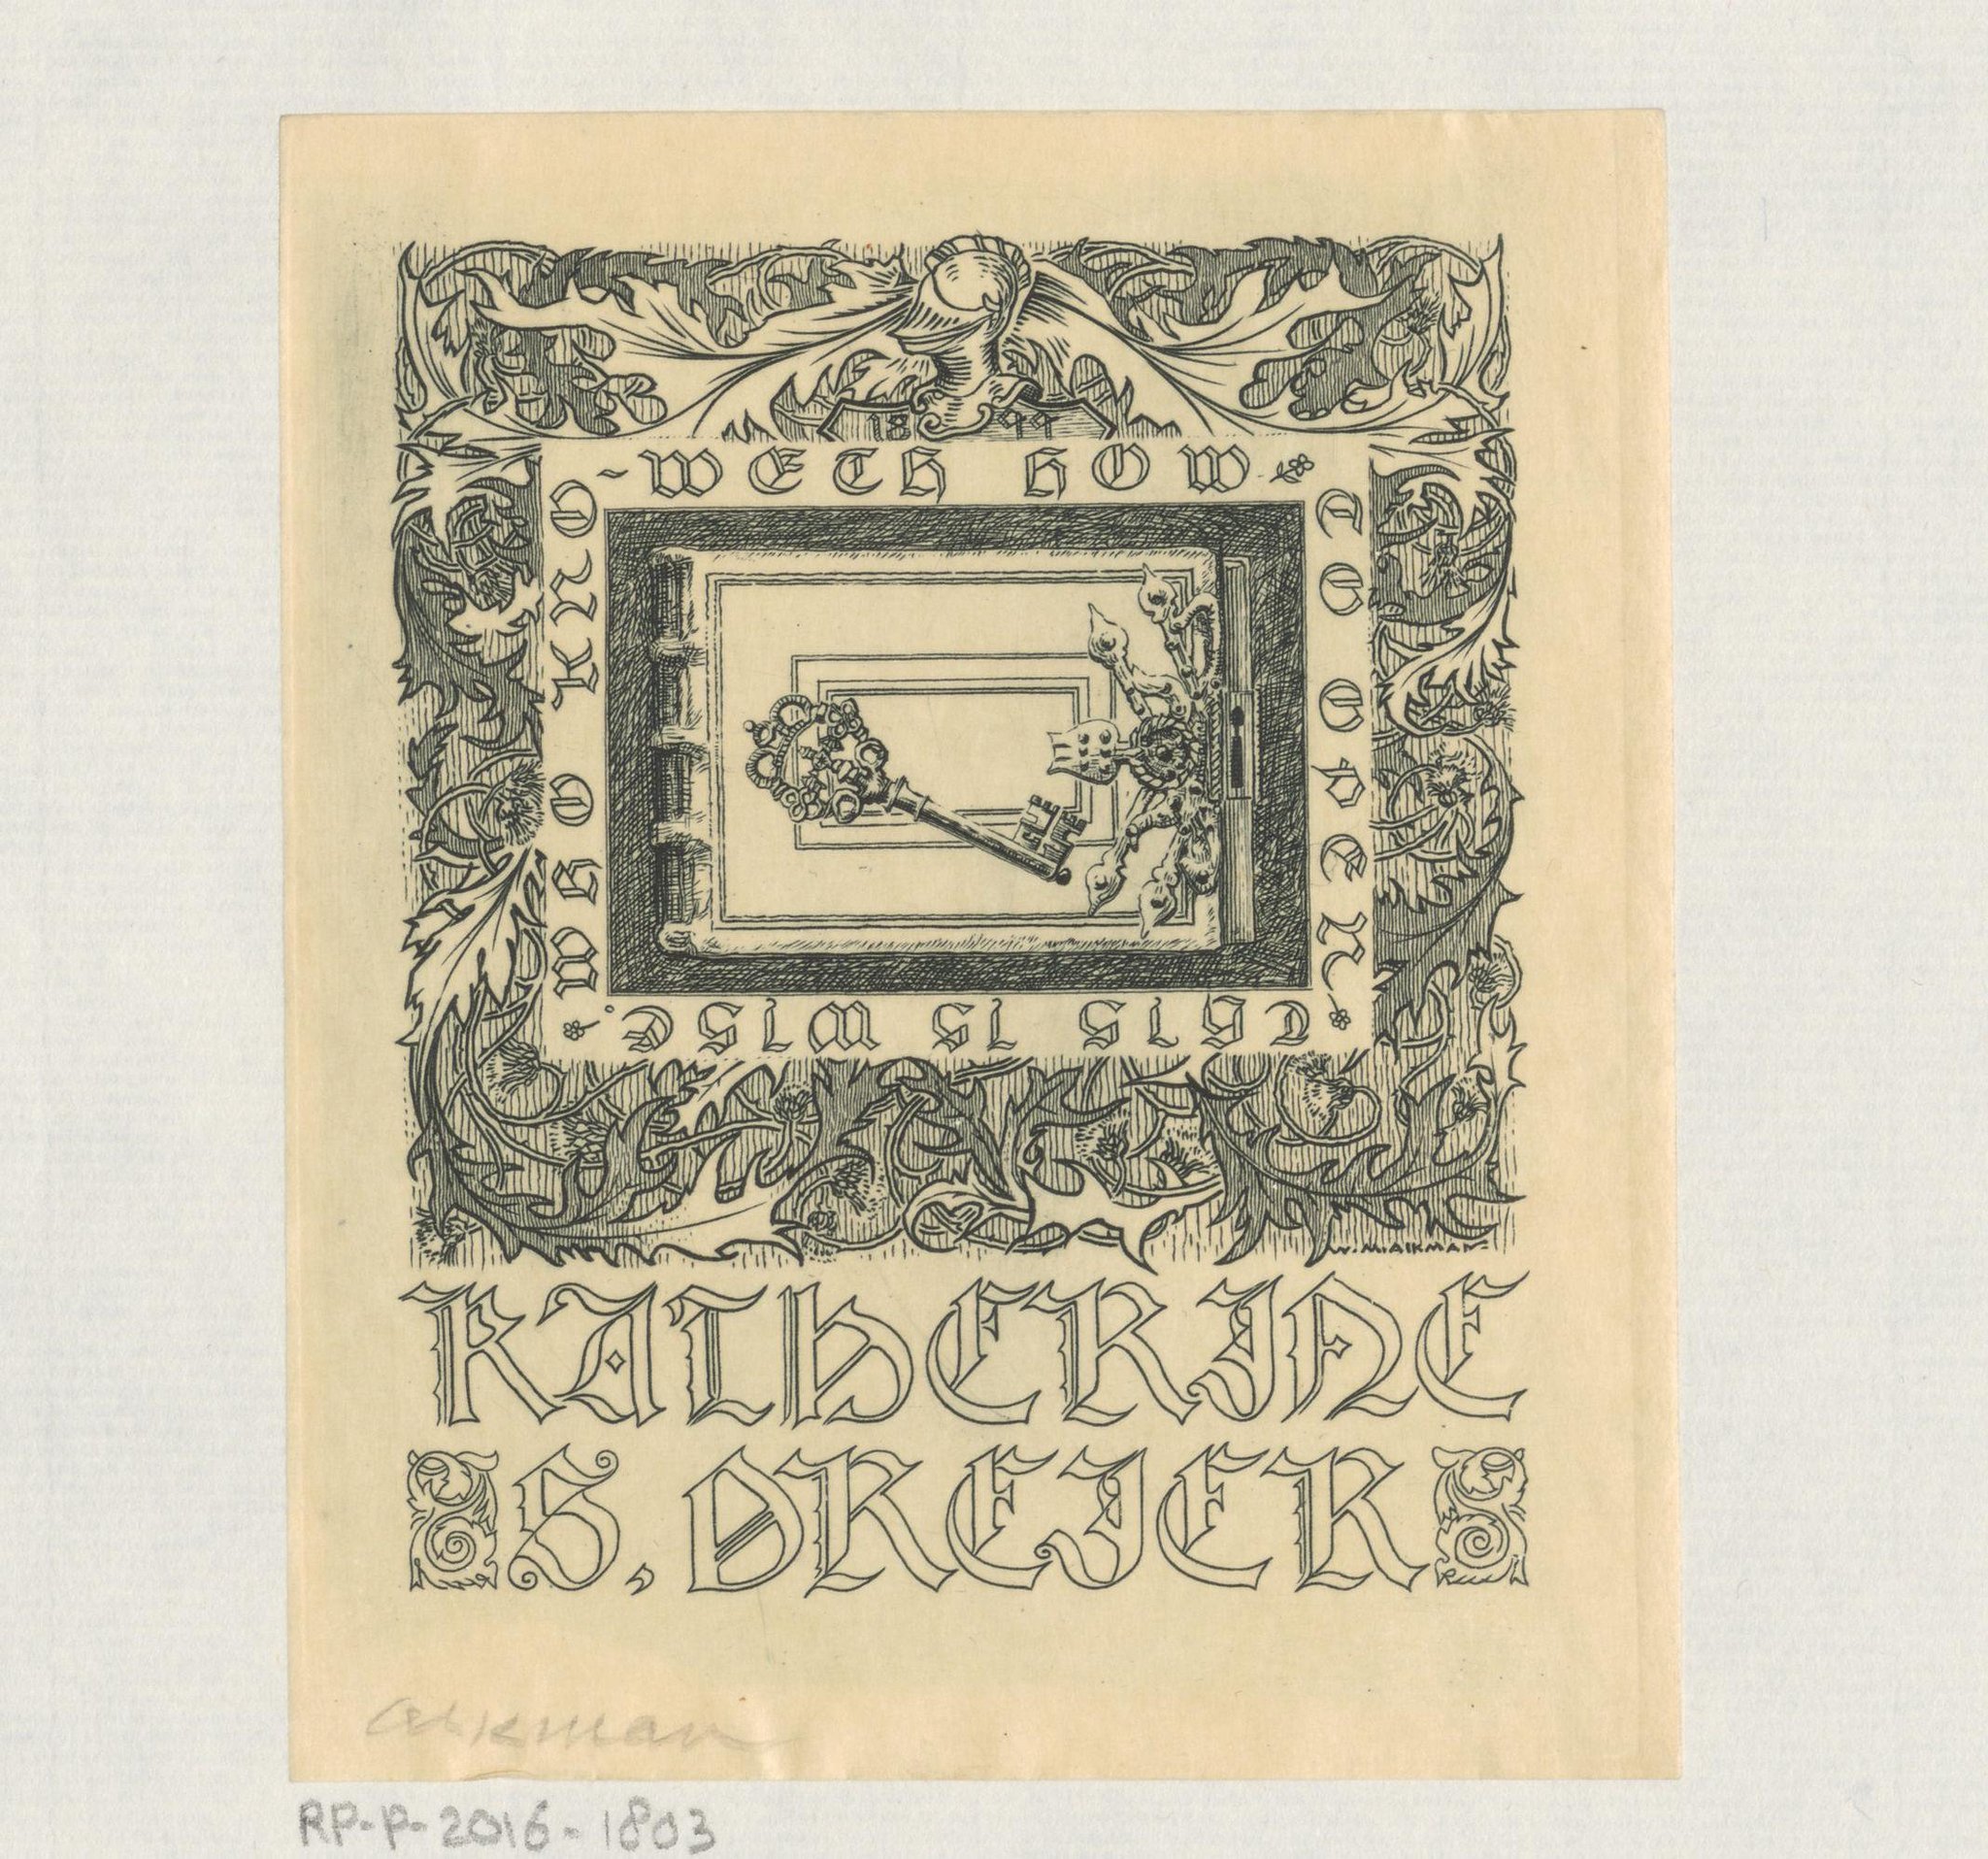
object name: bookplate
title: Ex libris van Katherine S. Dreier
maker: walter montieth aikman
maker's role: designer, print maker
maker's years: 1857-1939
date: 1877-1939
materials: paper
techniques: engraving, etching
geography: new york city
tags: lock ~ door, key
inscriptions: inscription: ‘Aikman’